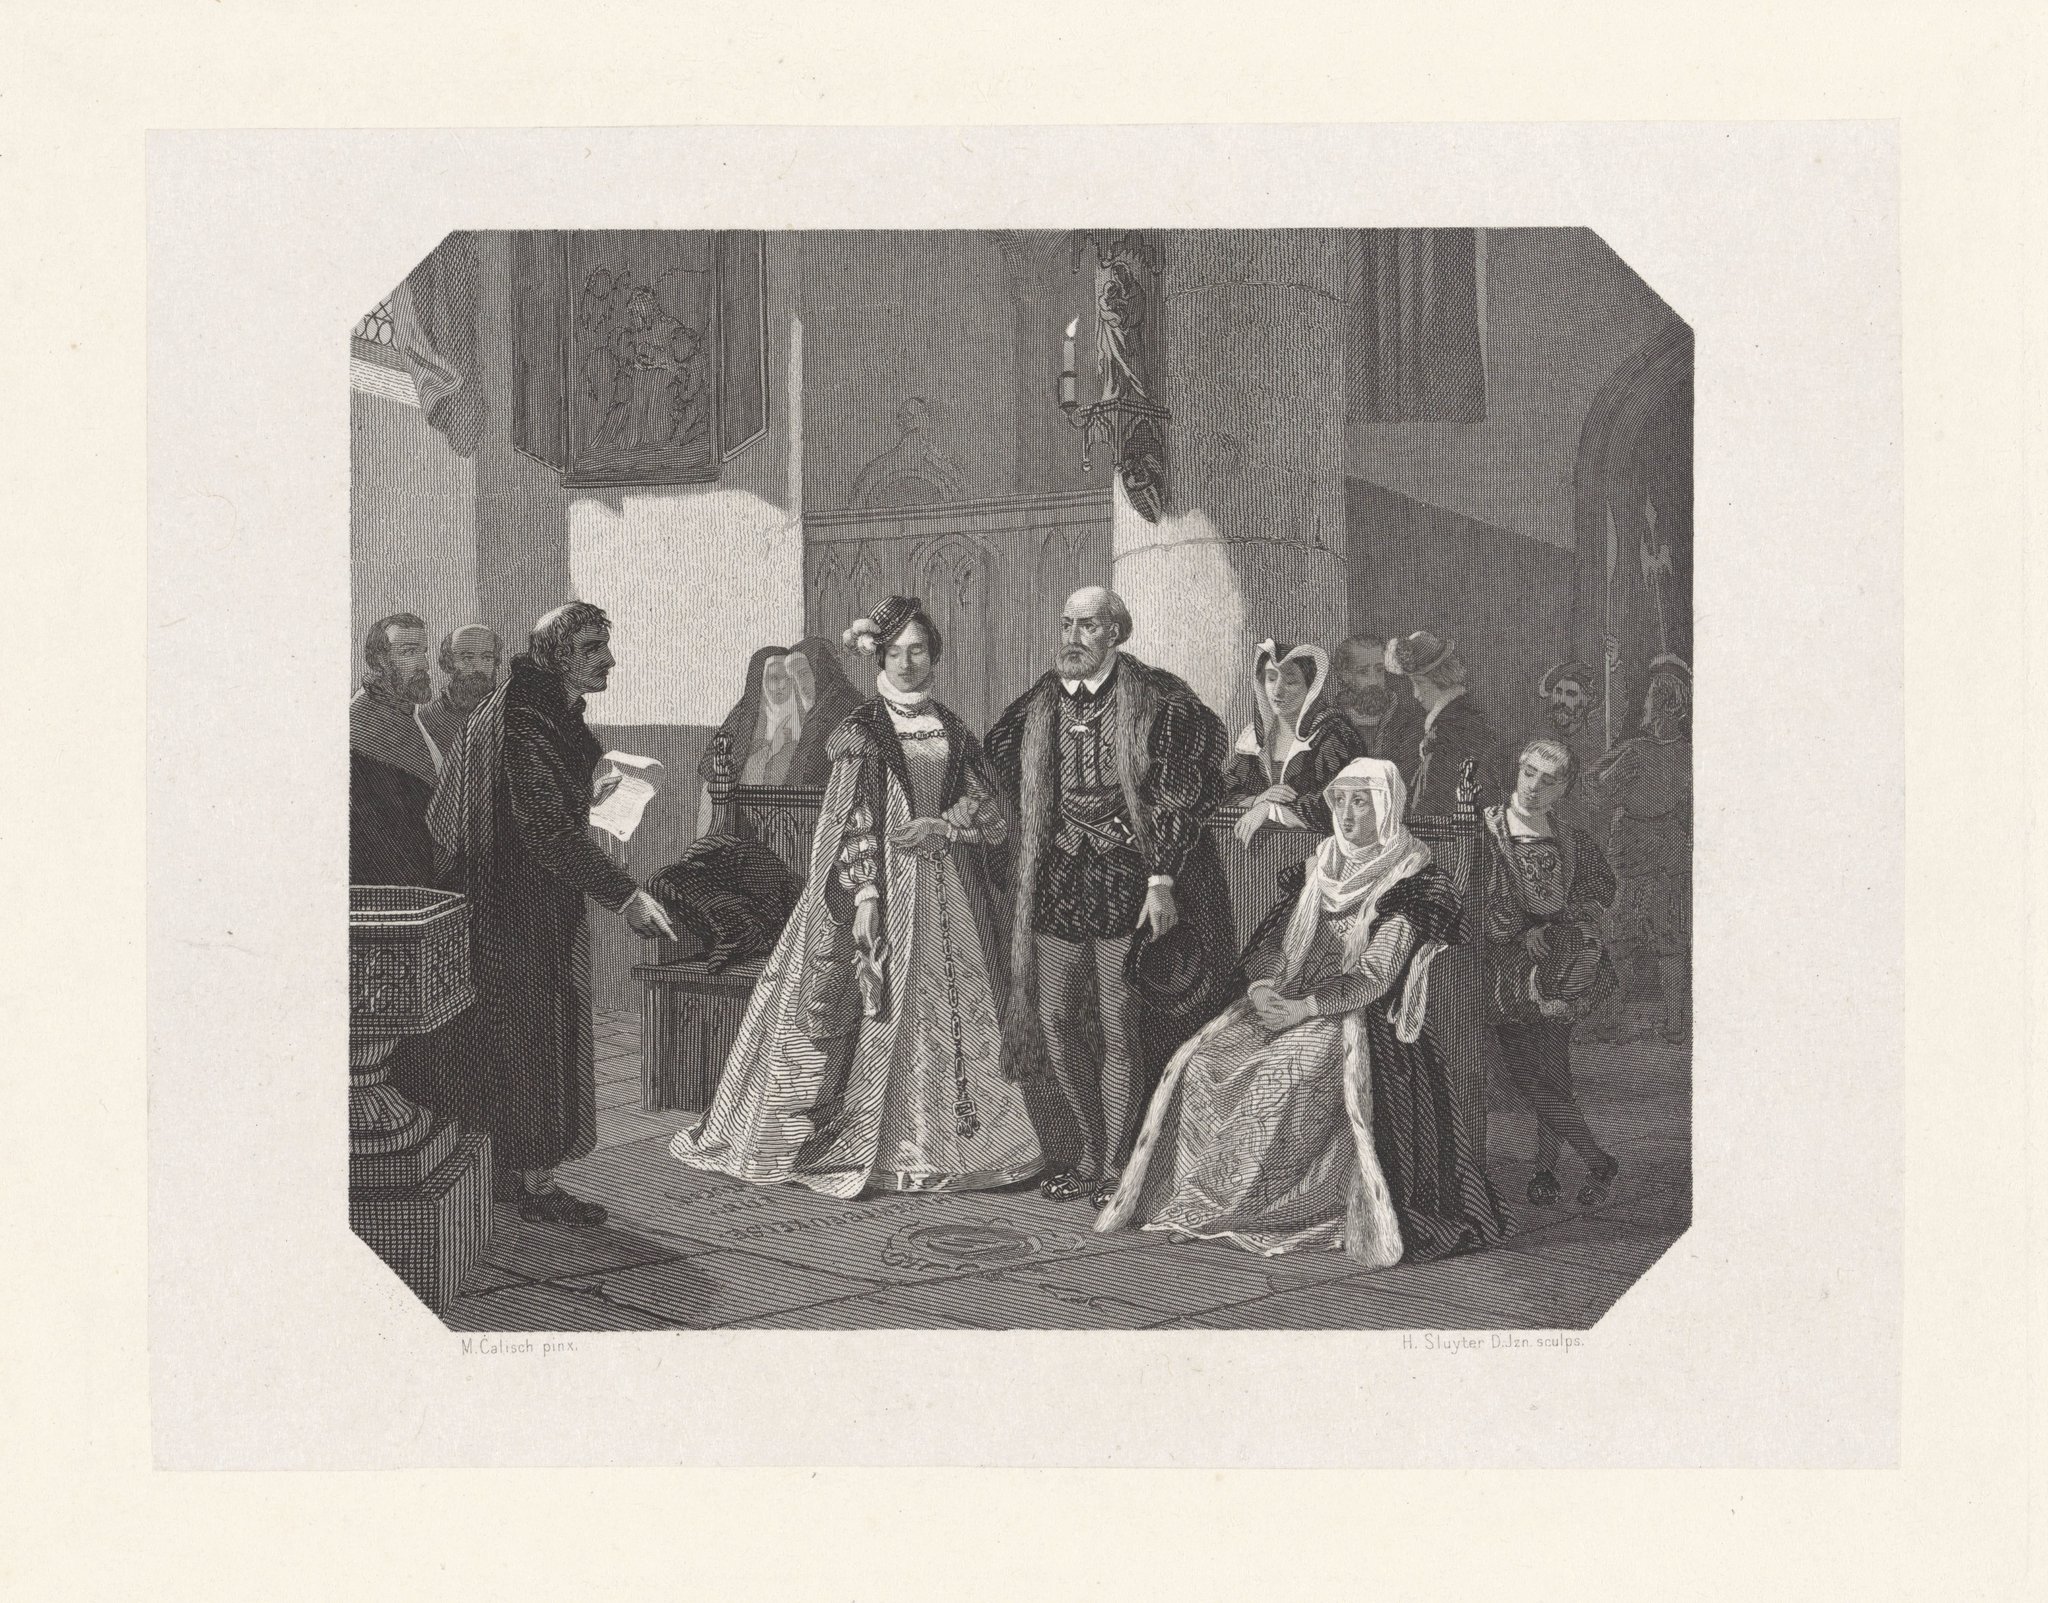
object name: book illustration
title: Keizer Karel V bij het graf van Willem Beukelszoon in 1556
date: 1865-1870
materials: paper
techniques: etching, engraving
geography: amsterdam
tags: ghent, charles v (holy roman emperor and king of spain), monk(s), friar(s), parts of church interior, gravestone, tombstone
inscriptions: collector's mark: Lugt 2228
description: Illustratie voor: J. van Lennep en W. Moll en J. ter Gouw. Nederlands geschiedenis en volksleven in schetsen. Leiden: A.W. Sijthoff [ca. 1870]. Staalgravures naar de schilderijen van de Historische Galerij der Maatschappij Arti en Amicitiae.